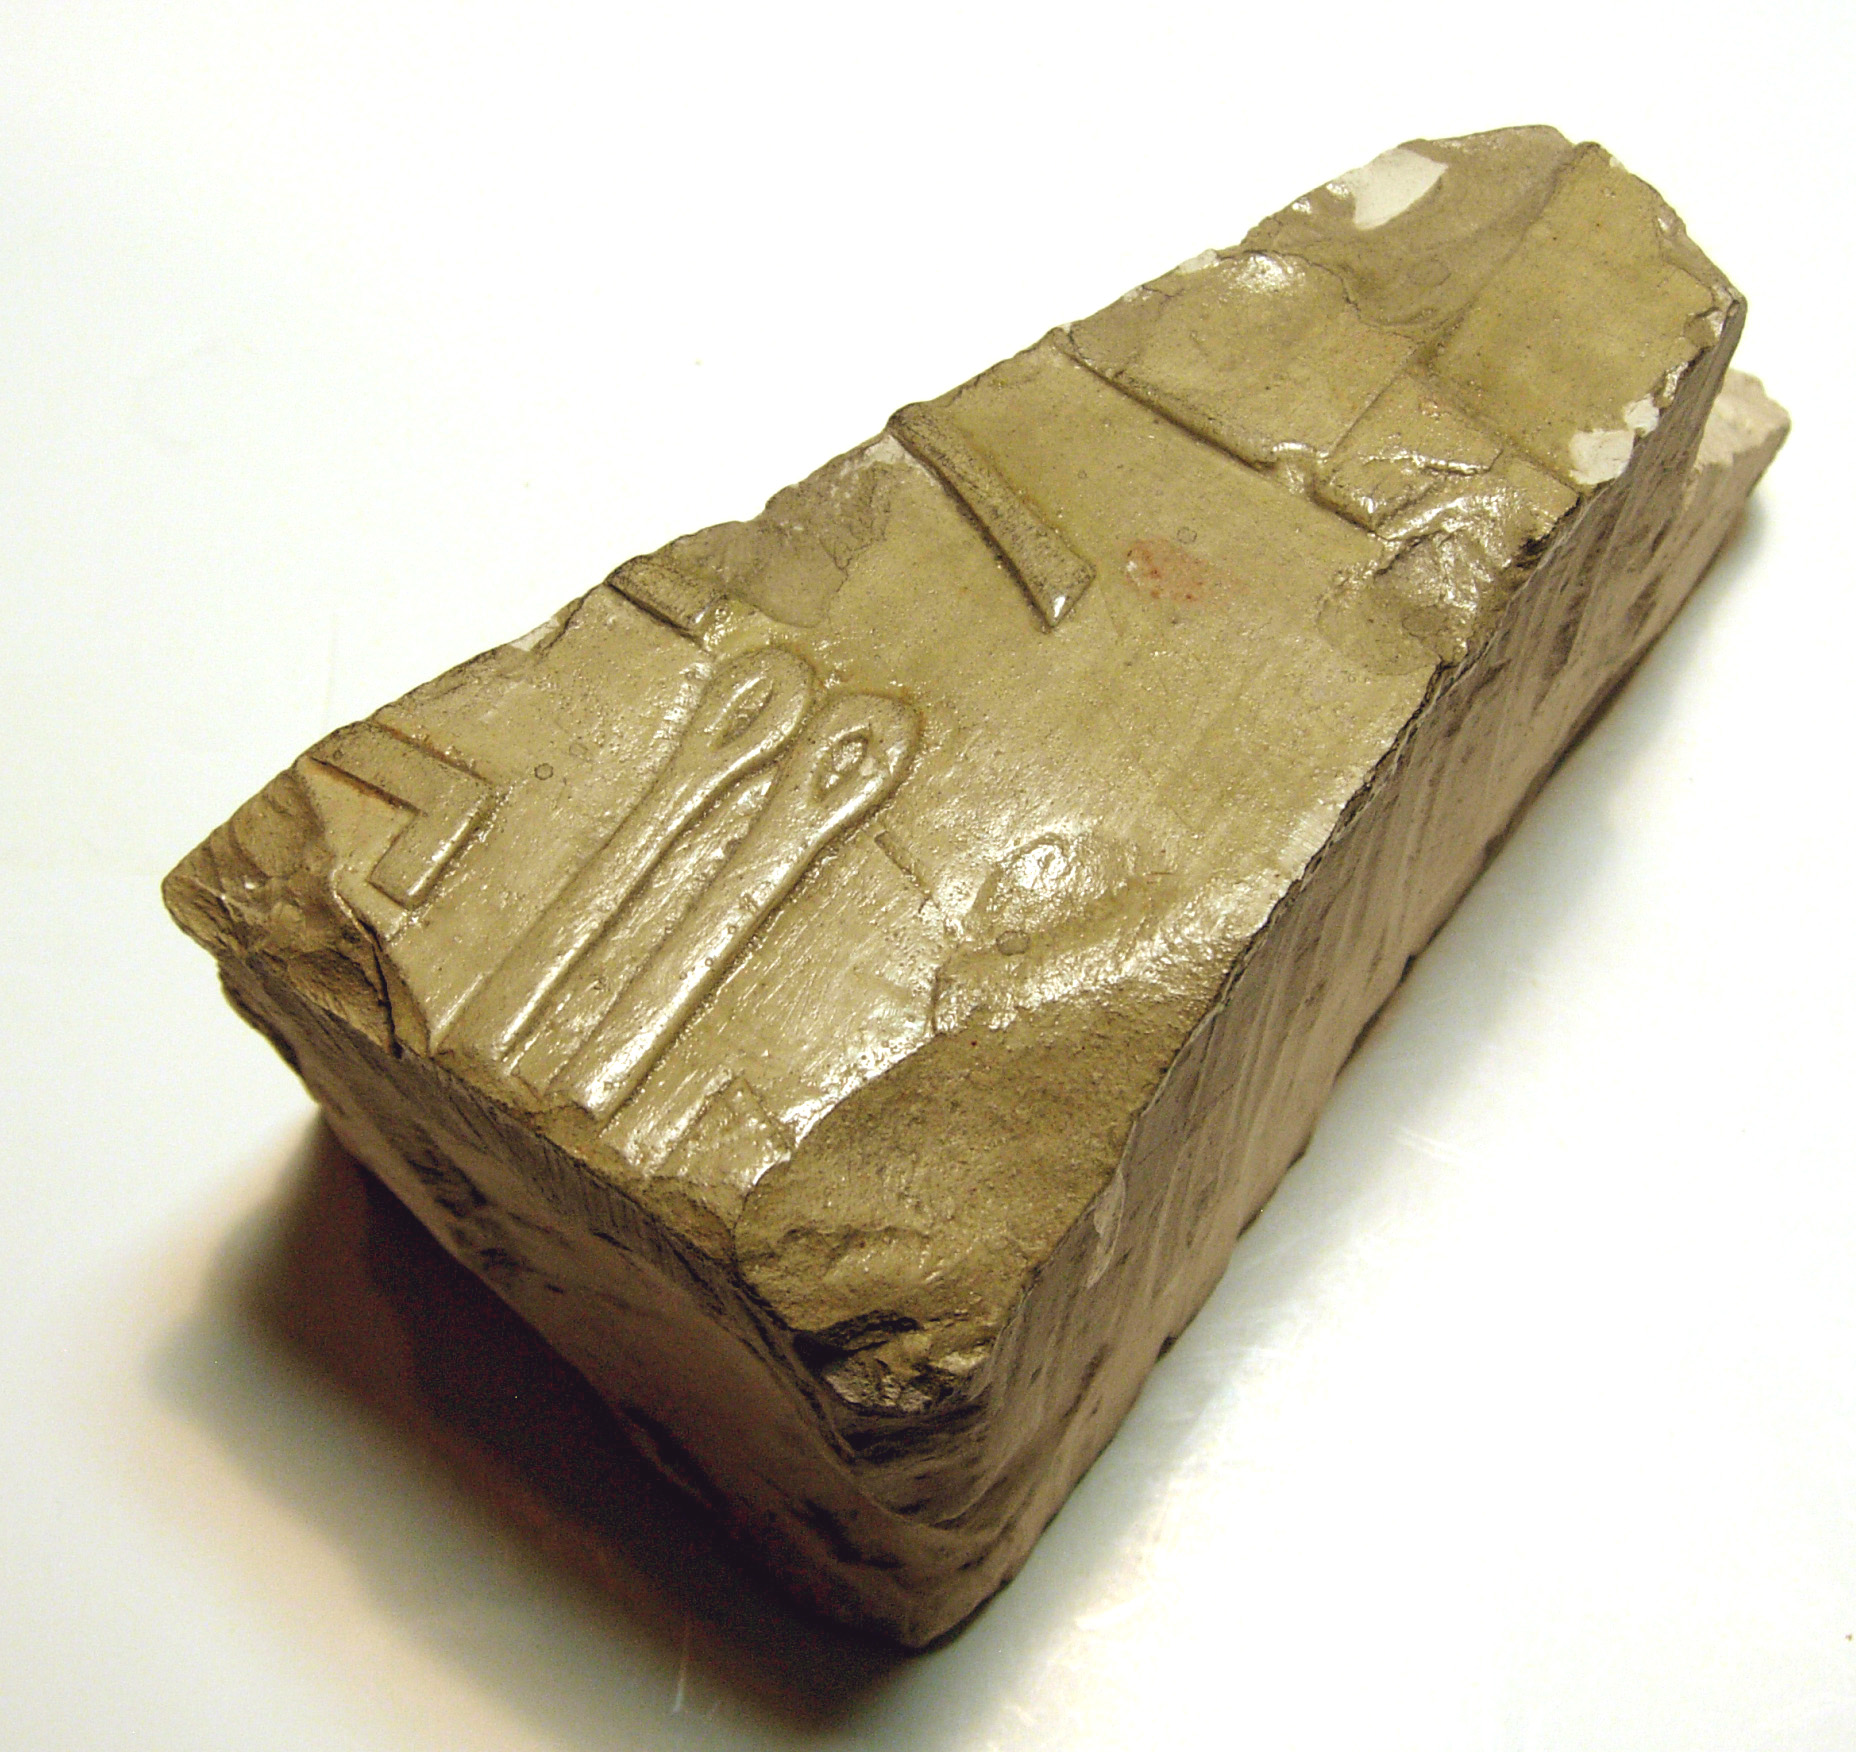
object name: relief, tomb of nespekashuty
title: Raised relief fragment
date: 664-610 BCE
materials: limestone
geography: egypt